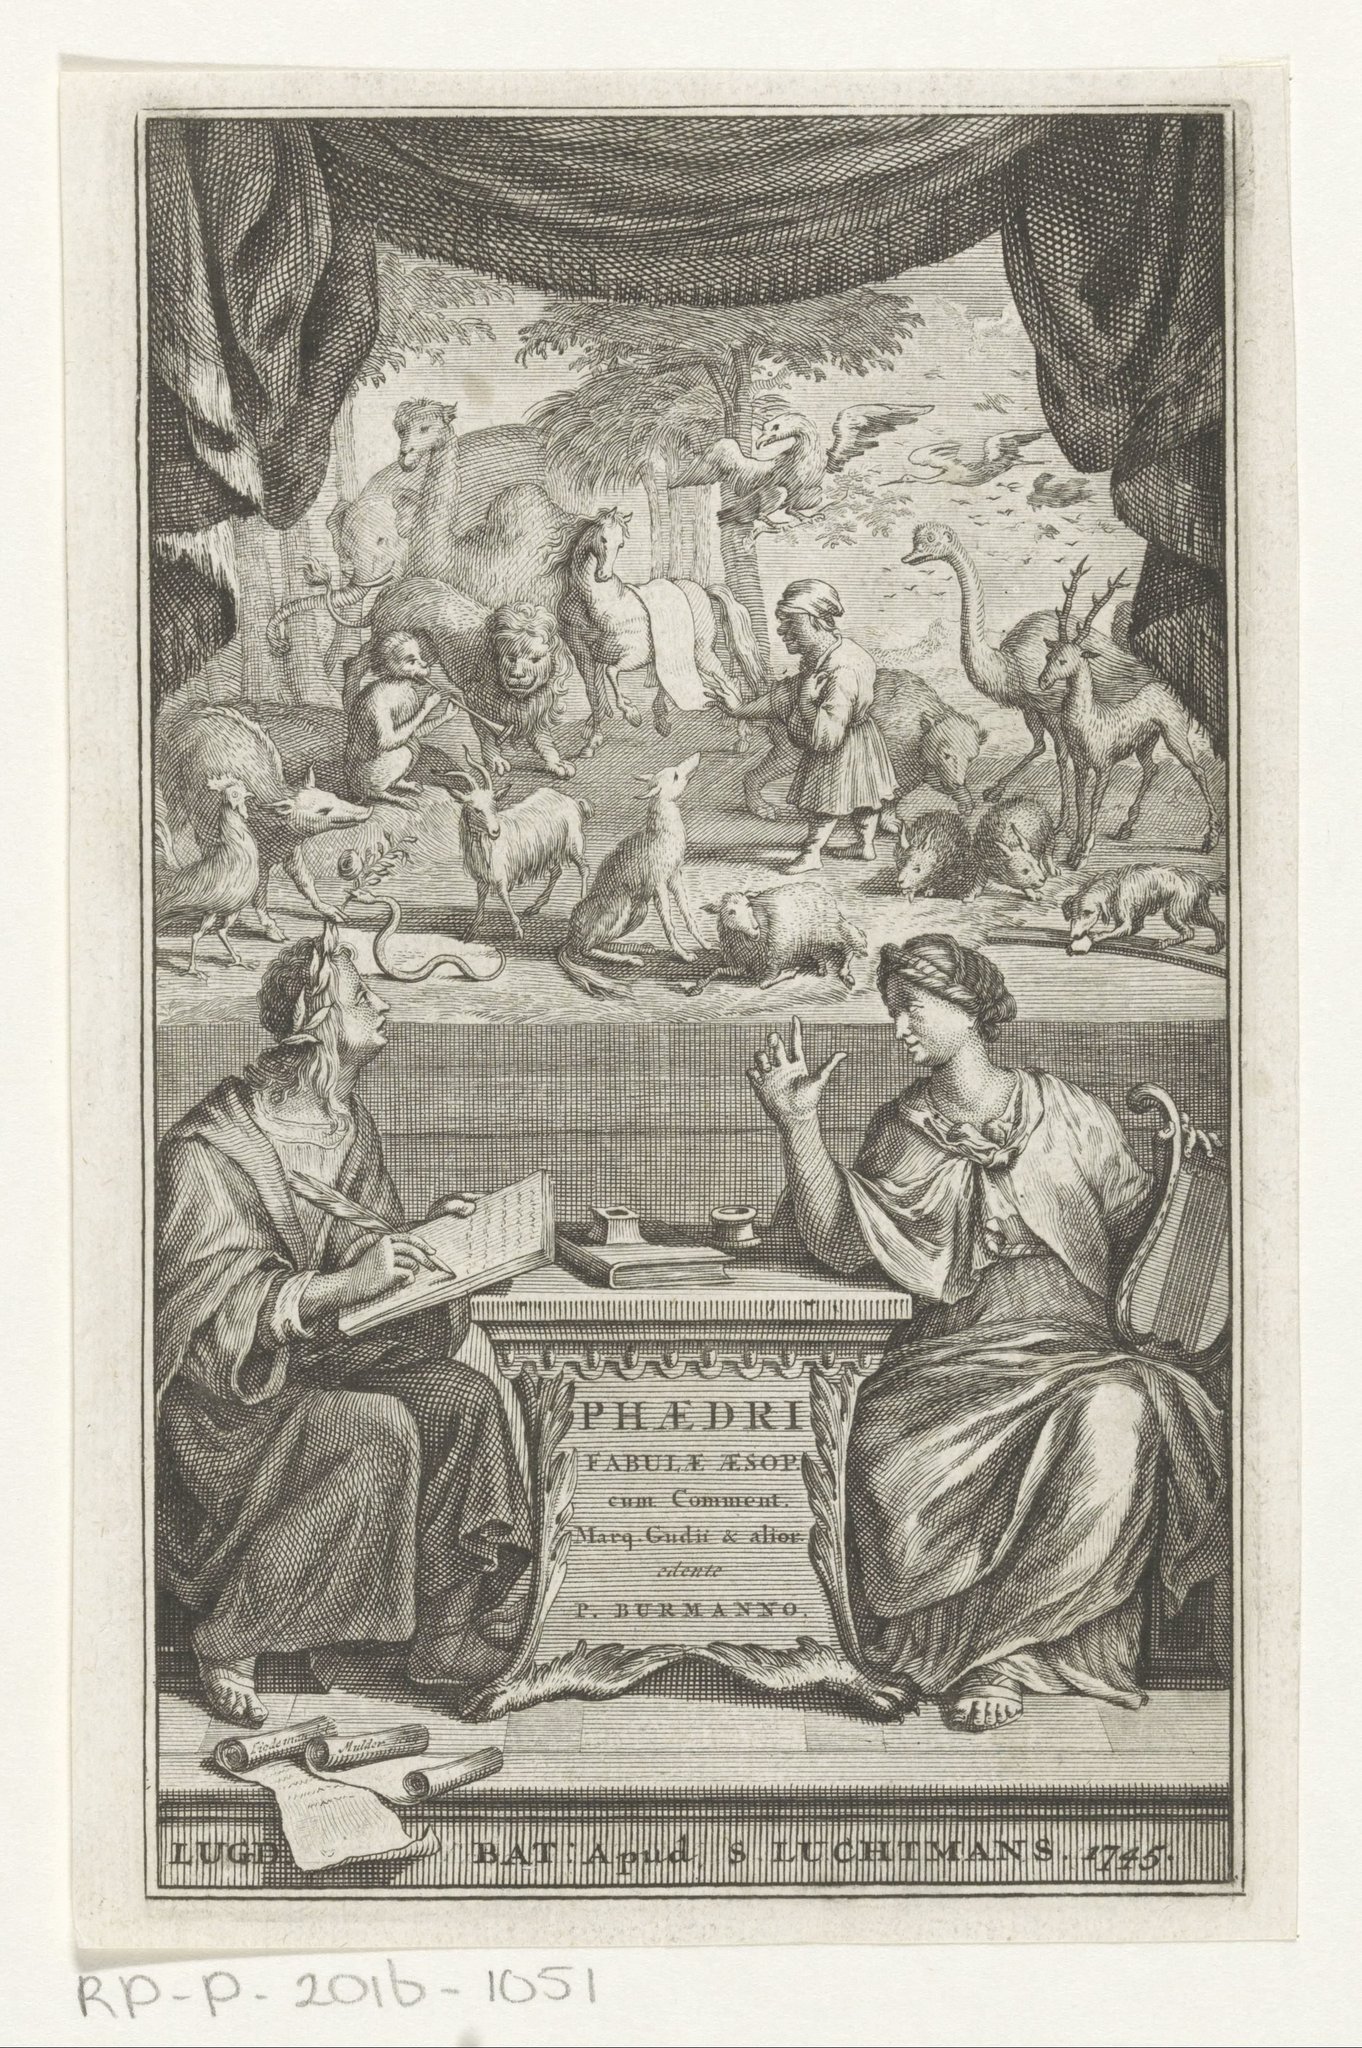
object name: titelblad, titelpagina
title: Schrijver, muze en dieren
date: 1745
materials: paper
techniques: engraving, etching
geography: leiden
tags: fables of aesop : use 85(...), writer, poet, author, terpsichore (one of the muses); 'terpsicore' (ripa)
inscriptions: collector's mark: Lugt 2228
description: Bij een stenen tafel met boektitel schrijft een man, mogelijk Aesopus, op een tablet. Tegenover hem zit een vrouw met lier, mogelijk de muze Terpsichore. In de achtergrond op een toneel de dieren en een kleine mens die voorkomen in de fabels van Aesopus.